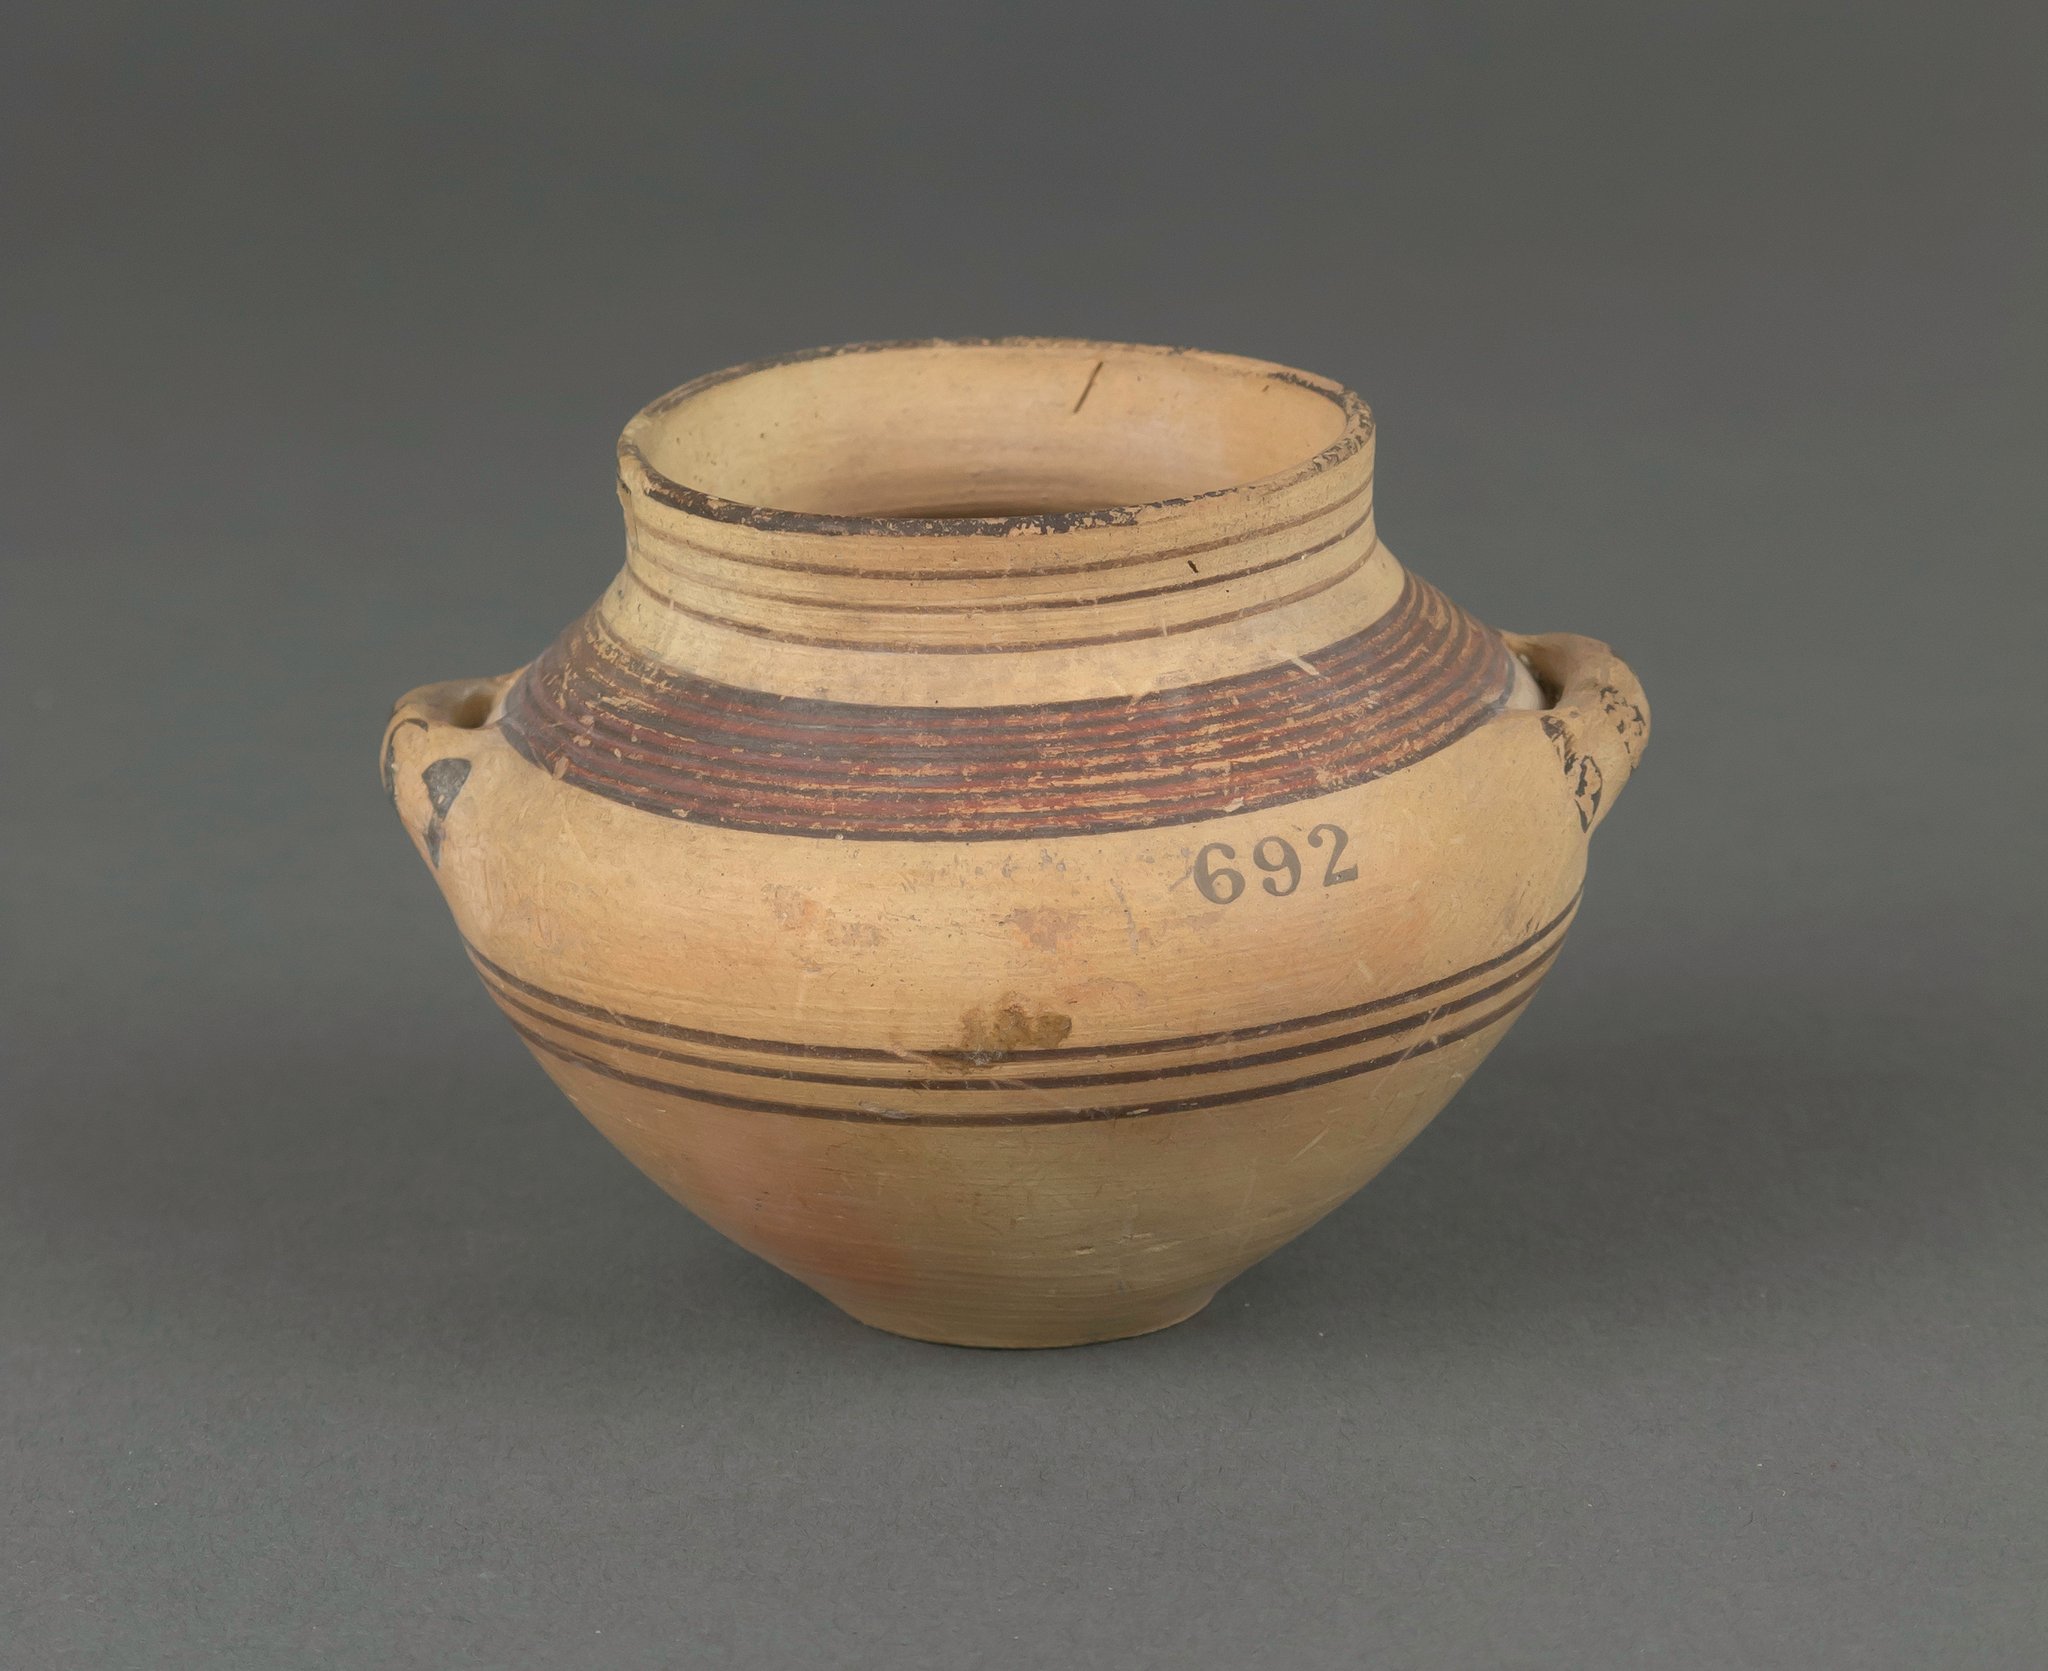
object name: dinos, miniature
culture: cypriot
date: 750-600 BCE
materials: terracotta